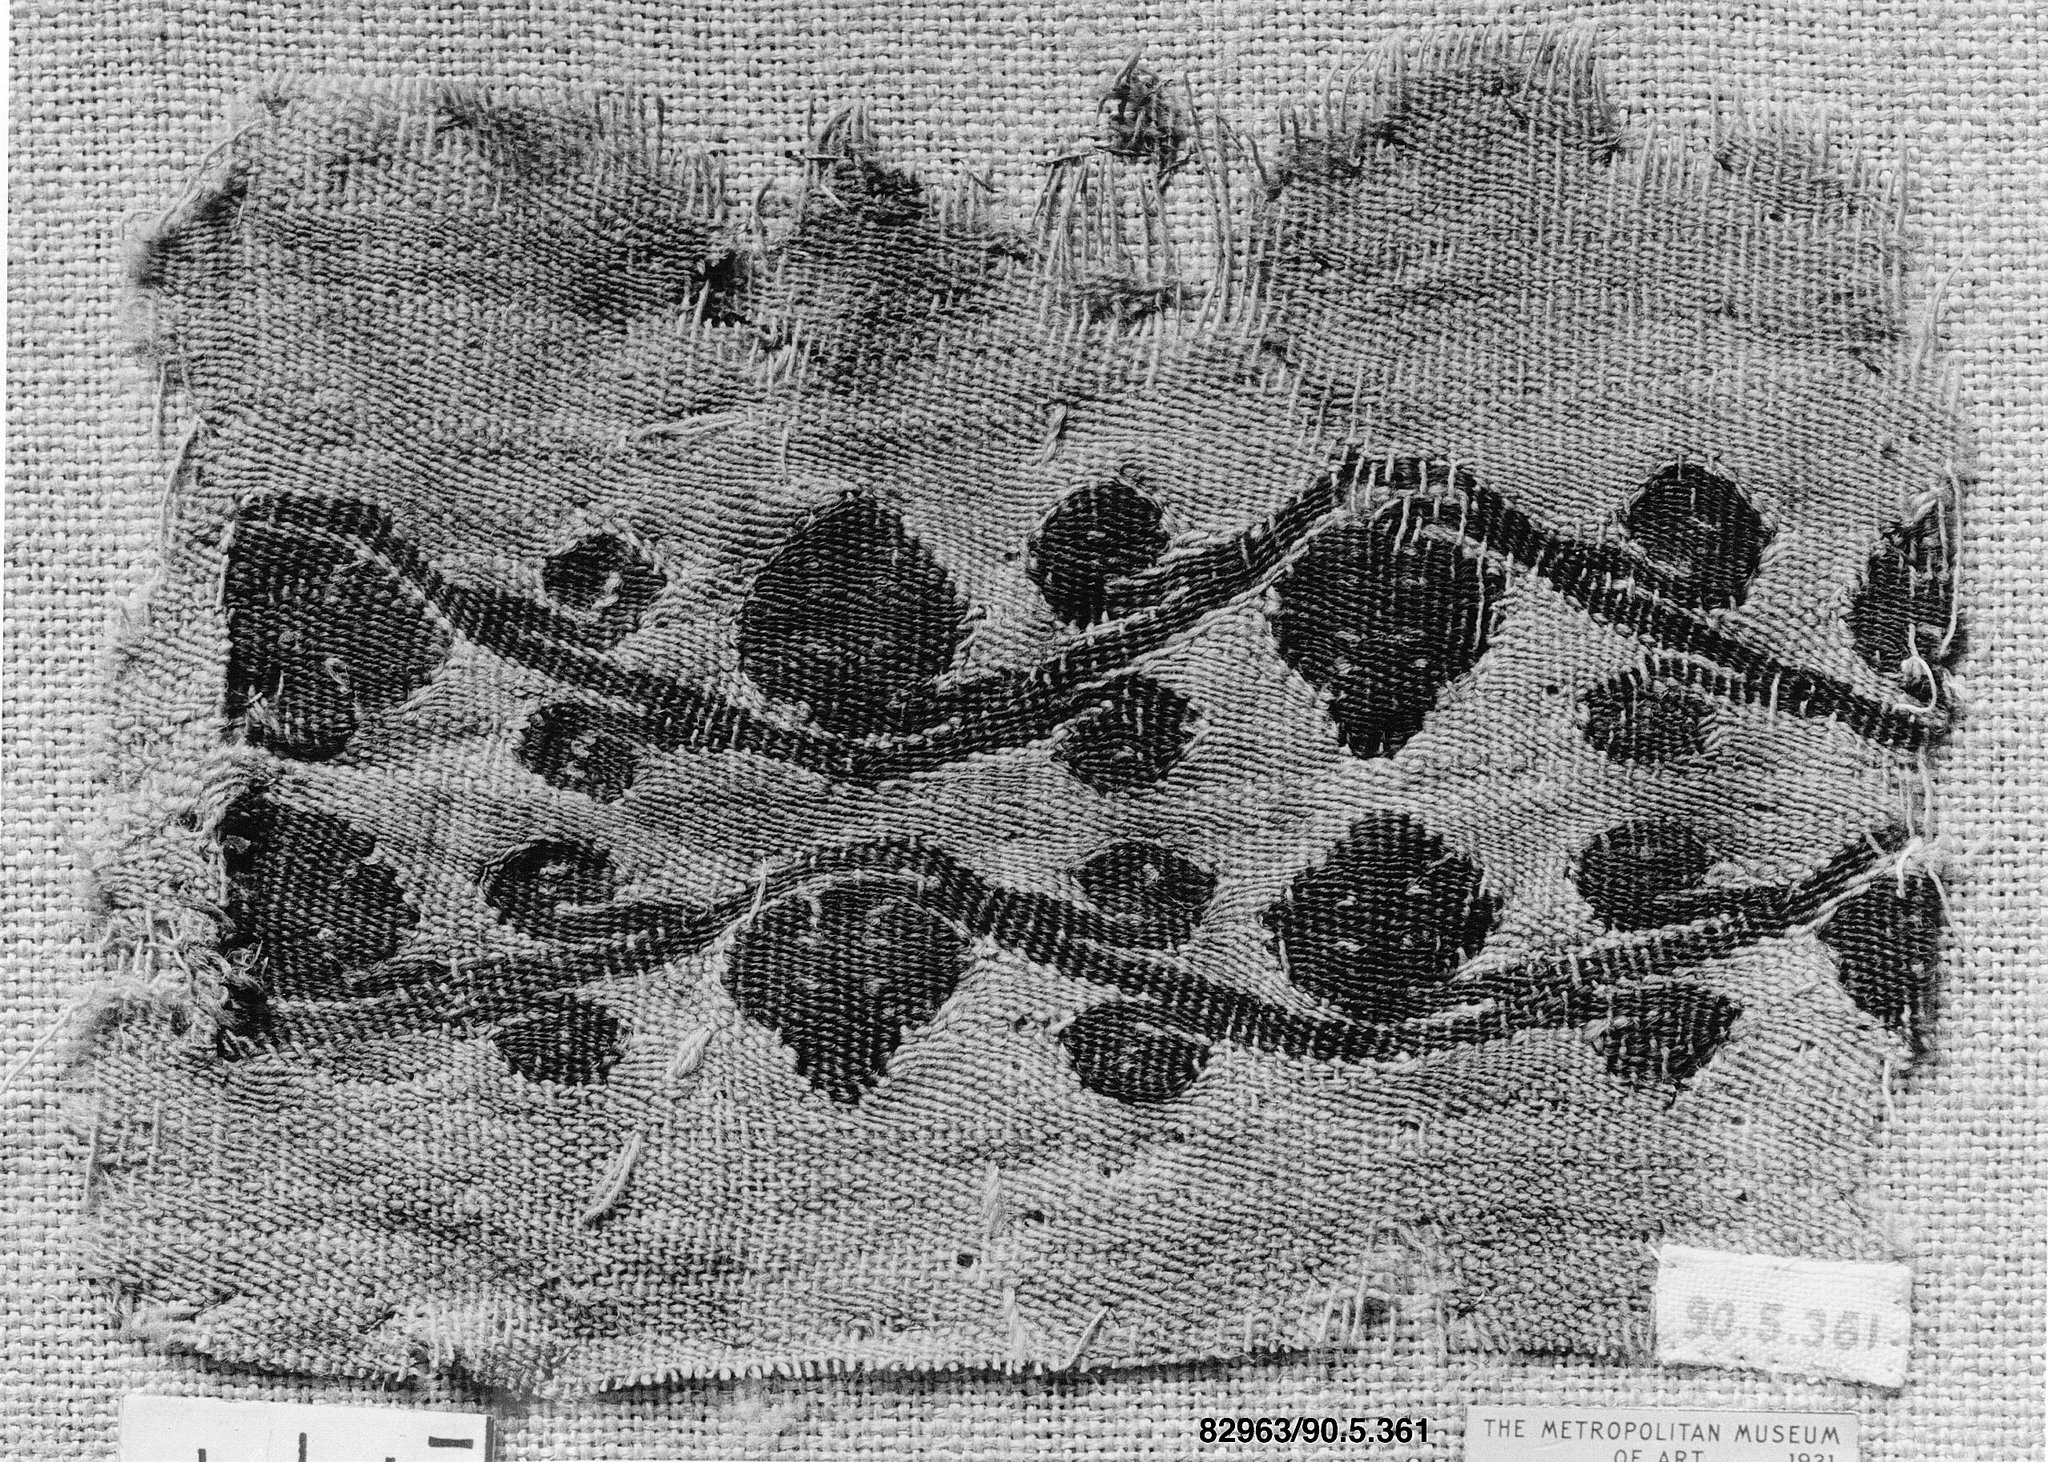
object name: textile fragment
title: Fragment of a Tunic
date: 201-400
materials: linen, wool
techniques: weave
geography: egypt